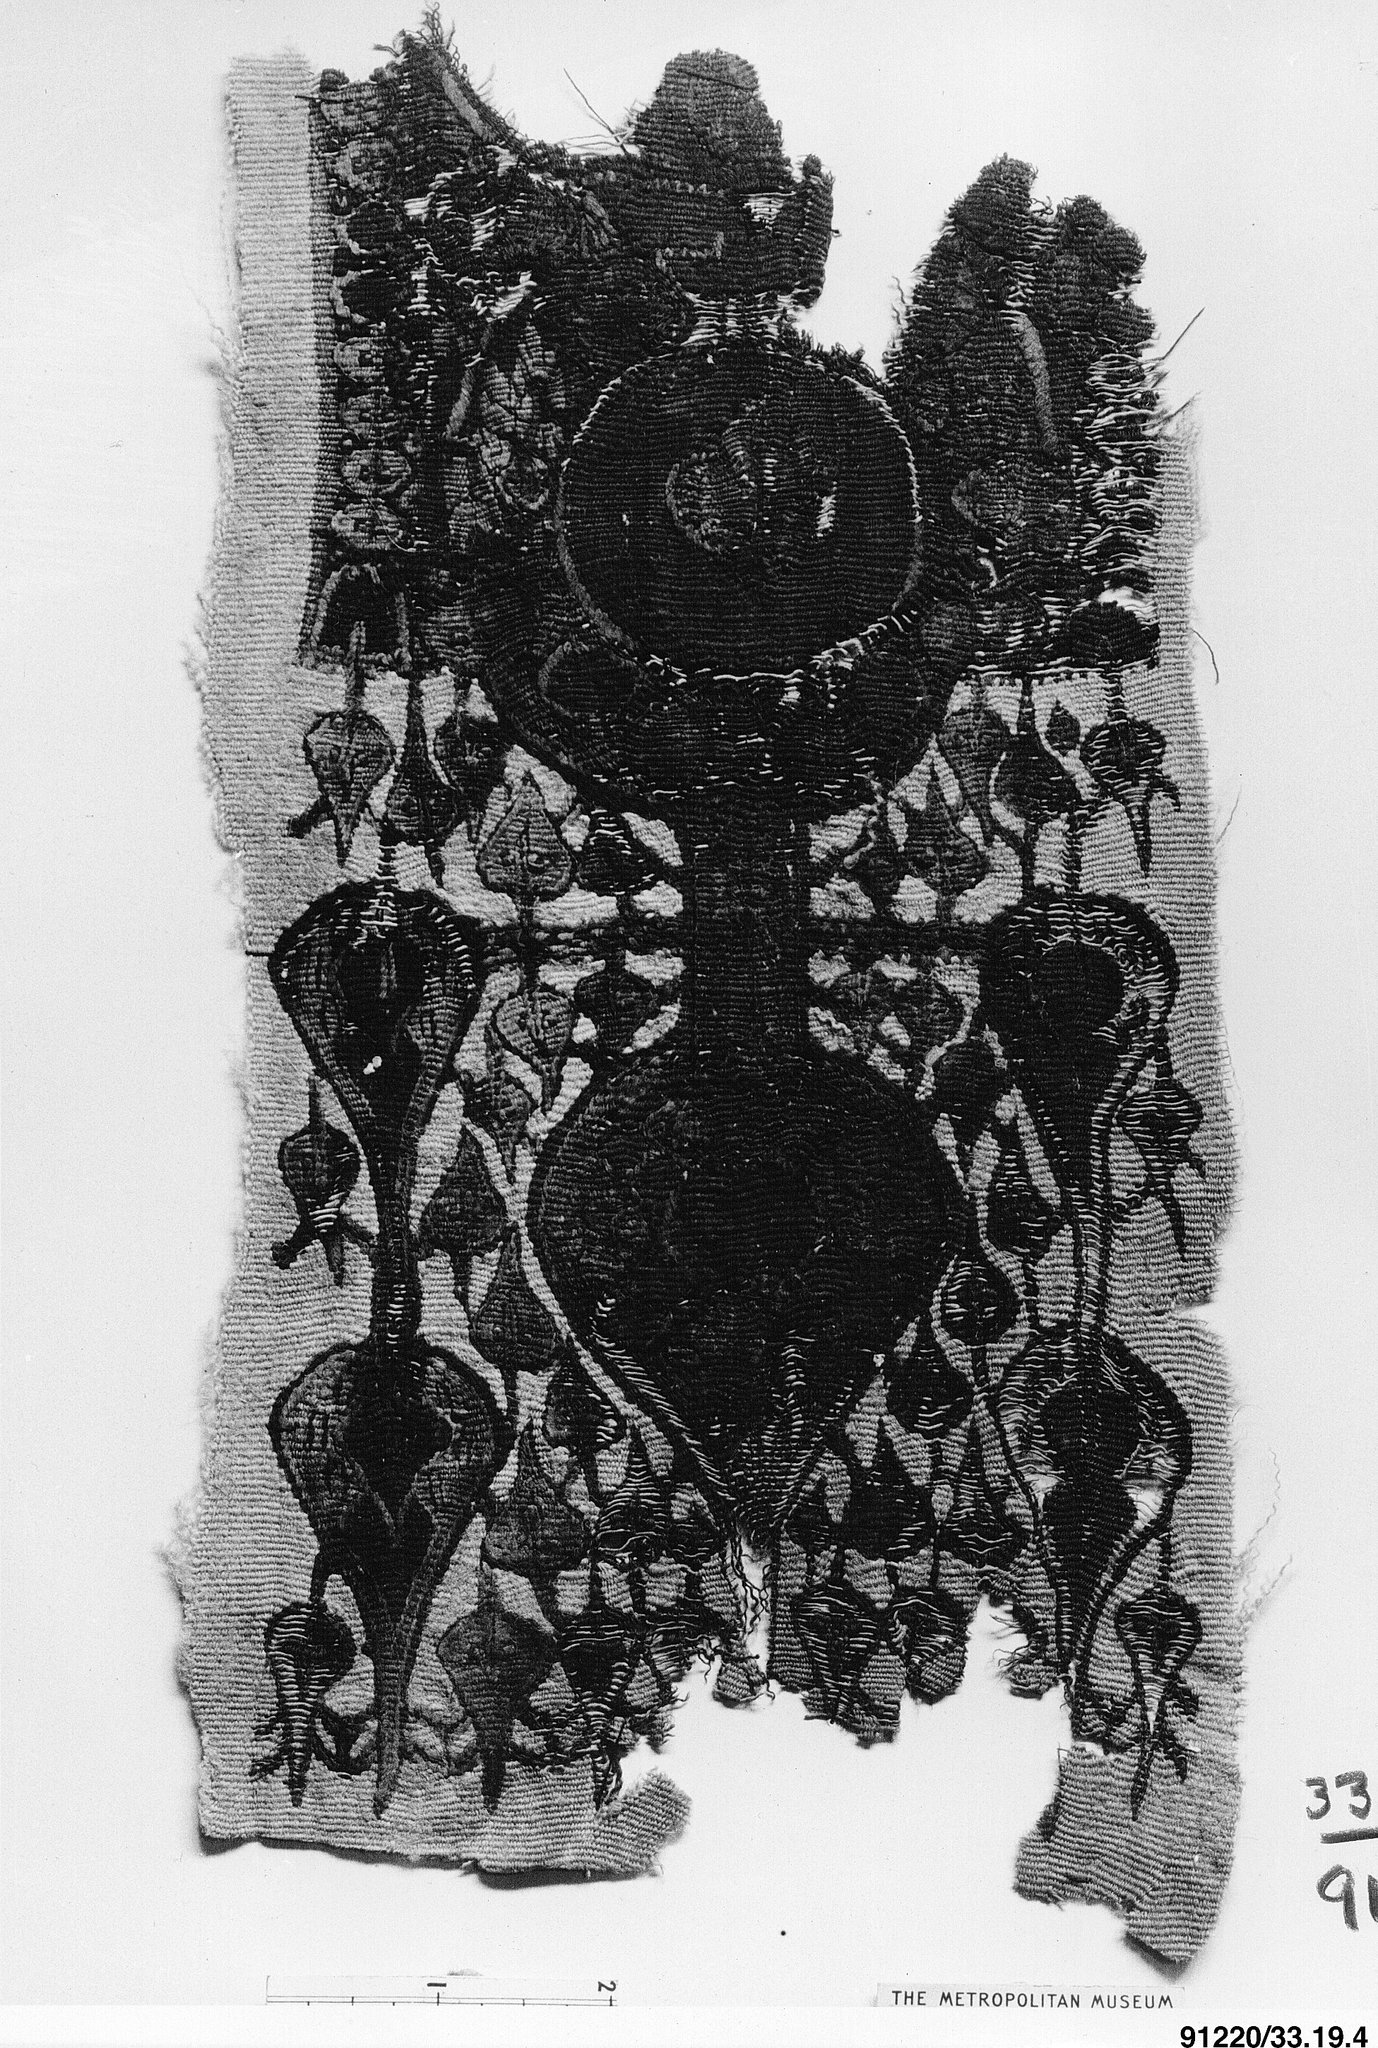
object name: textile fragment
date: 501-700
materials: wool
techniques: weave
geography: egypt